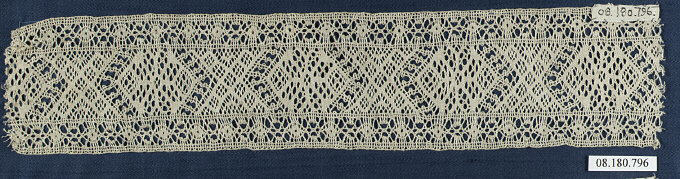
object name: insertion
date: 1801-1900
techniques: lace